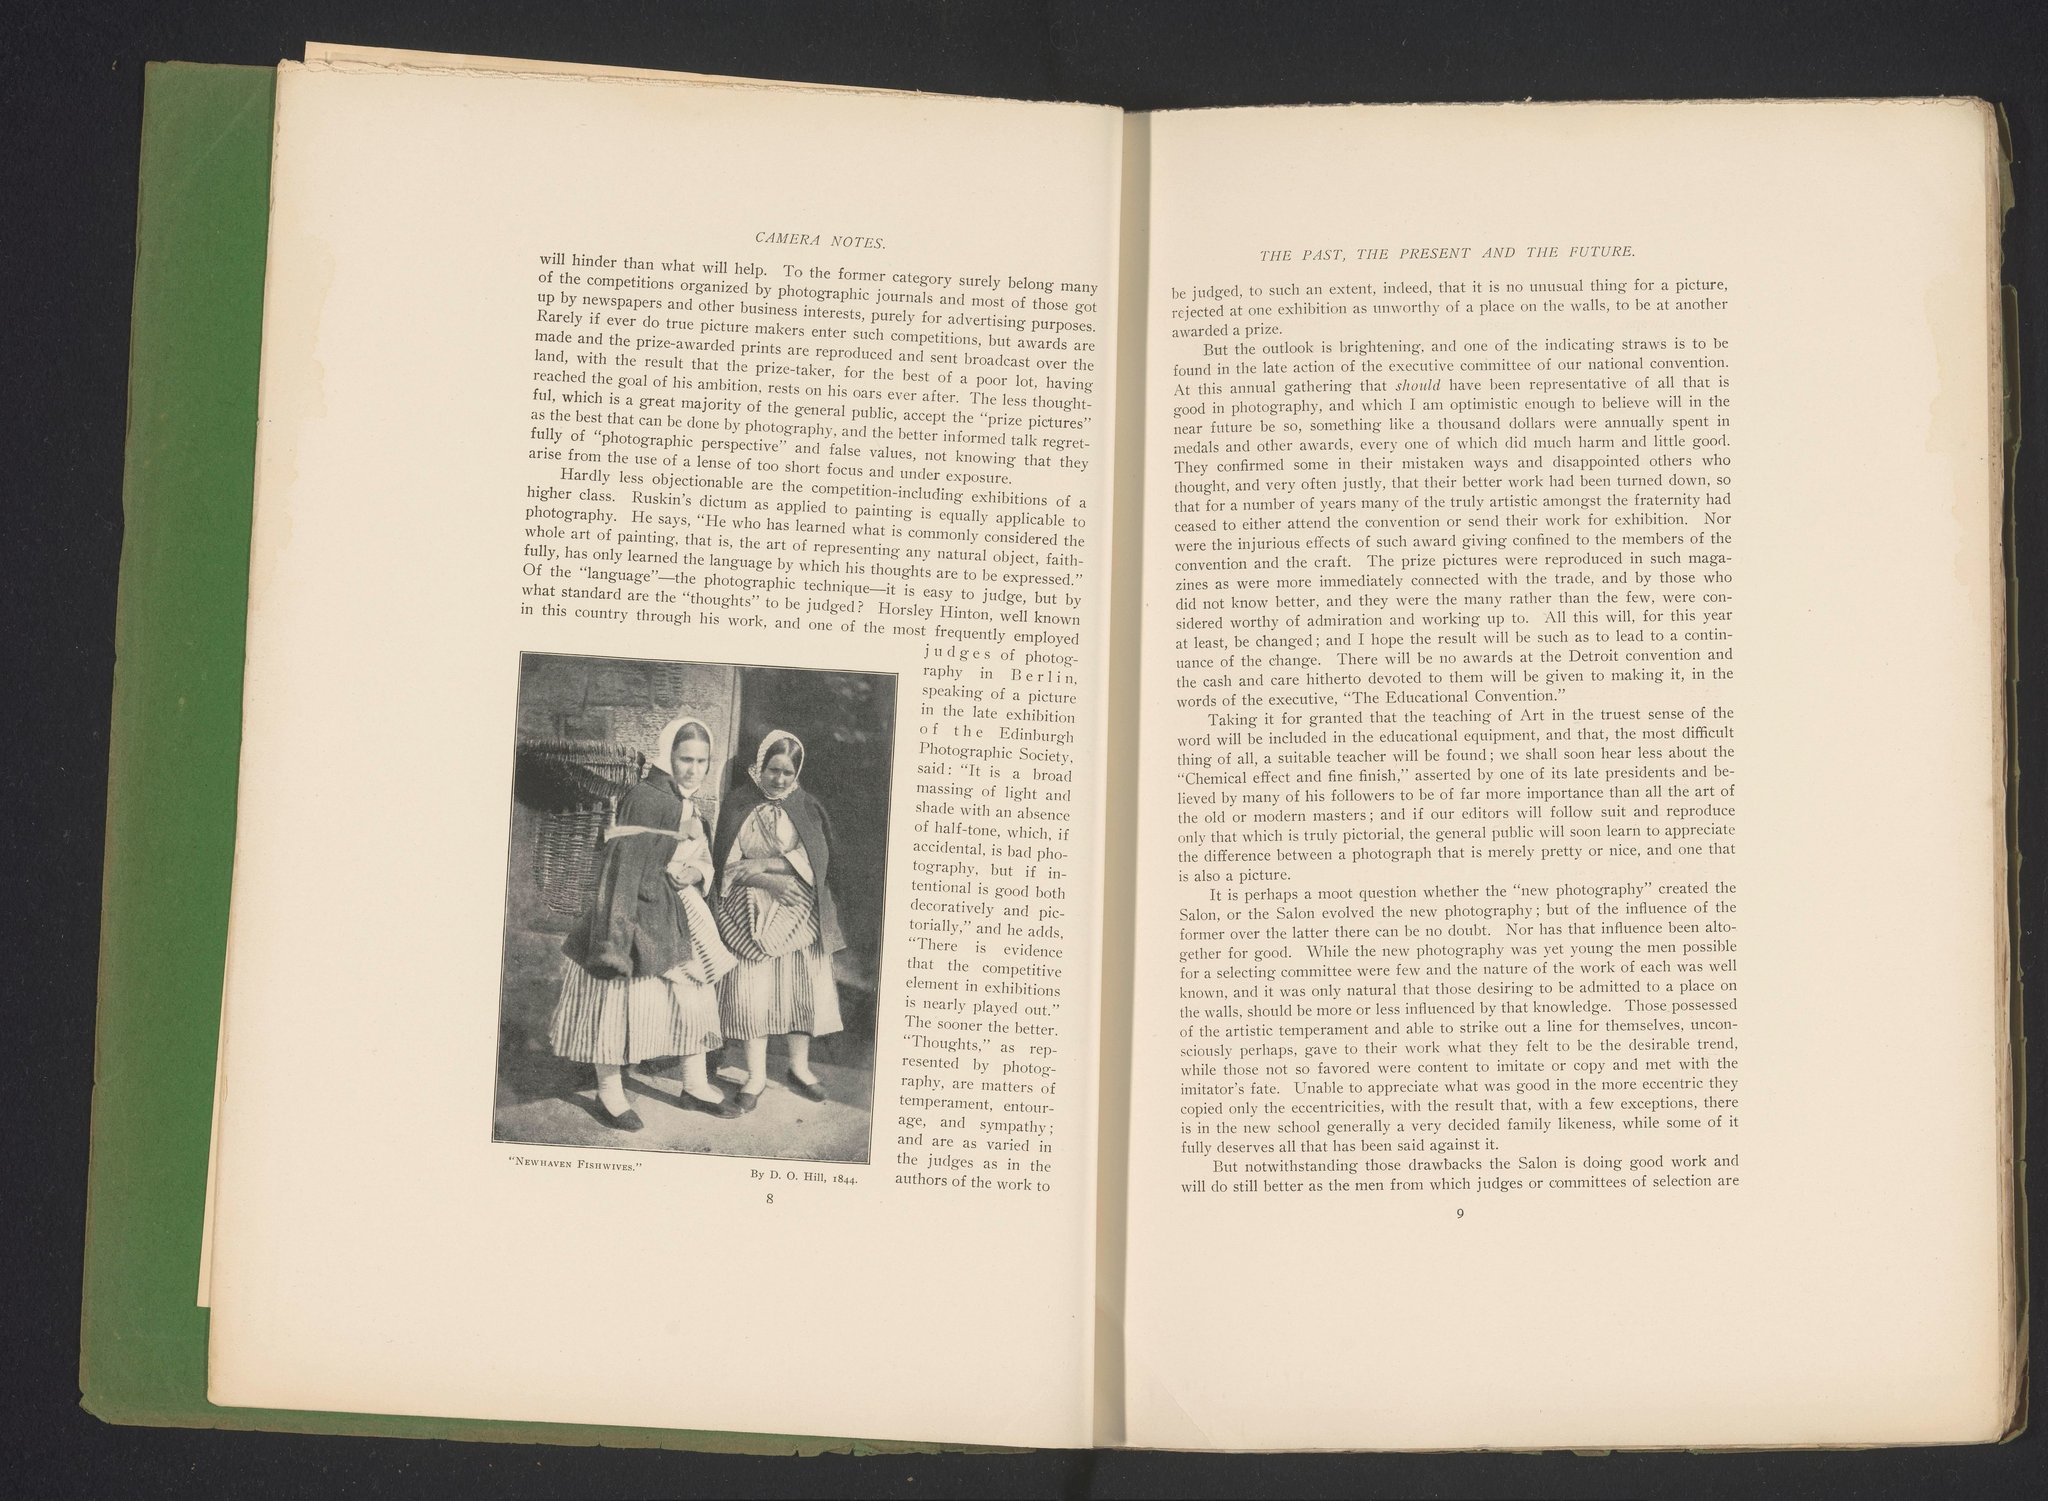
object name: page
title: Newhaven Fishwives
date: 1844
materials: paper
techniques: autotype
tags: adult woman, fisherman